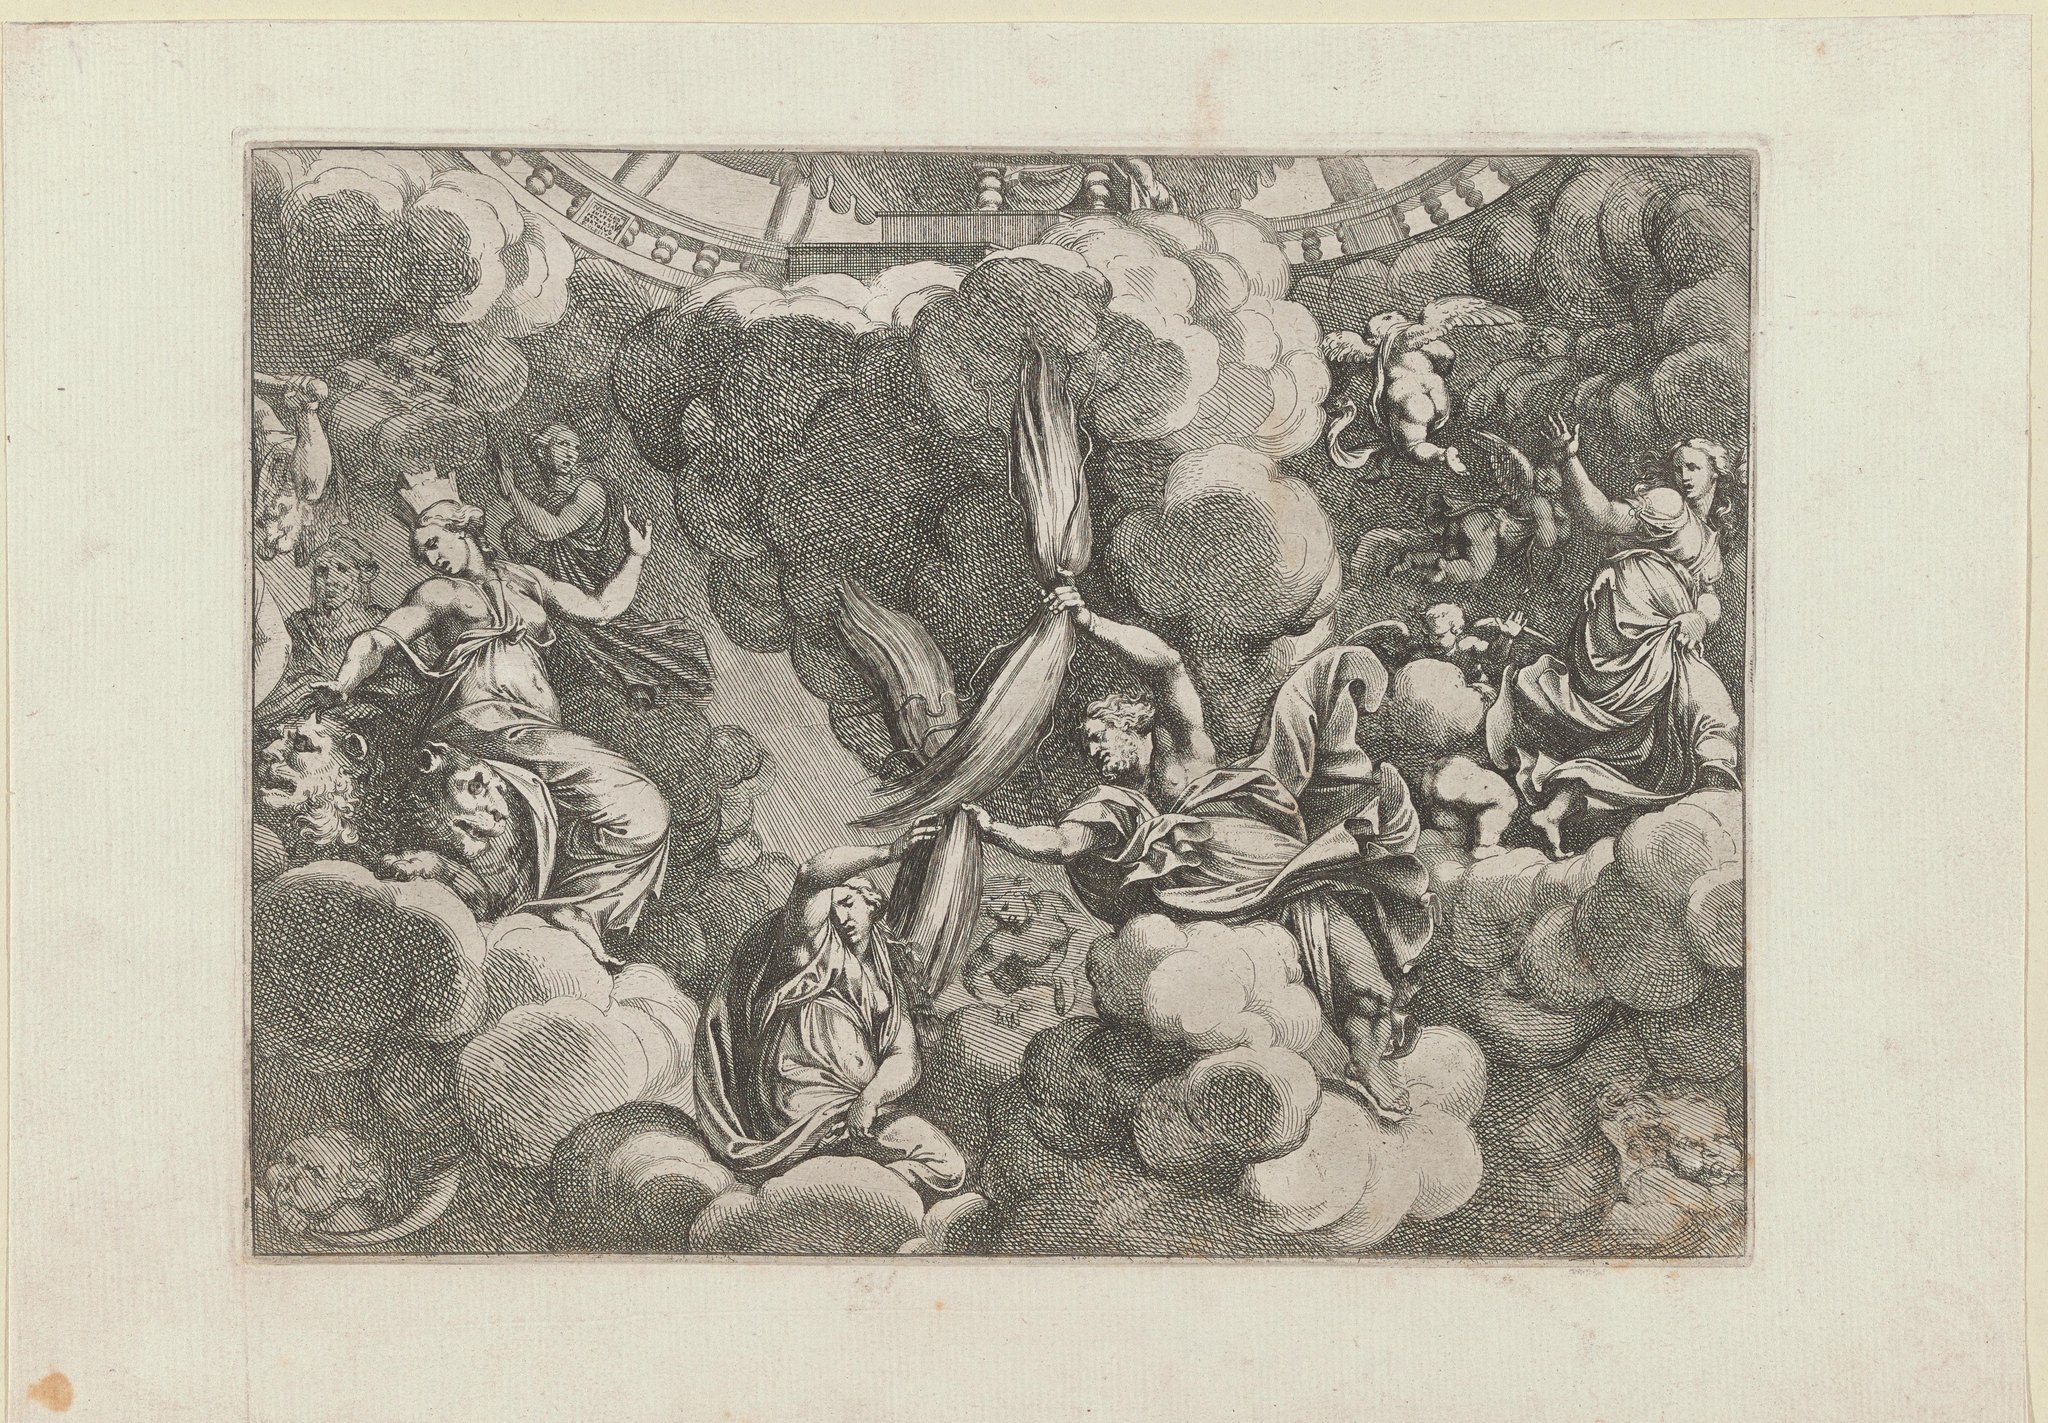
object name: print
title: Mythologische figuren tussen wolken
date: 1693-1700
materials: paper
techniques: engraving, etching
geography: rome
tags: (story of) cybele, rhea cybele, great mother of the gods (berecynt(h)ia), (story of) jupiter (zeus), cupids: 'amores', 'amoretti', 'putti'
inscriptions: collector's mark: Lugt 240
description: Deel van een plafondschildering met mythologische figuren tussen wolken. Centraal zit Jupiter met twee bundels bliksemschichten. Links zit de Frygische godin Cybele op twee leeuwen. Rechts vlucht een vrouwenfiguur omringd door putti. Boven een balustrade.